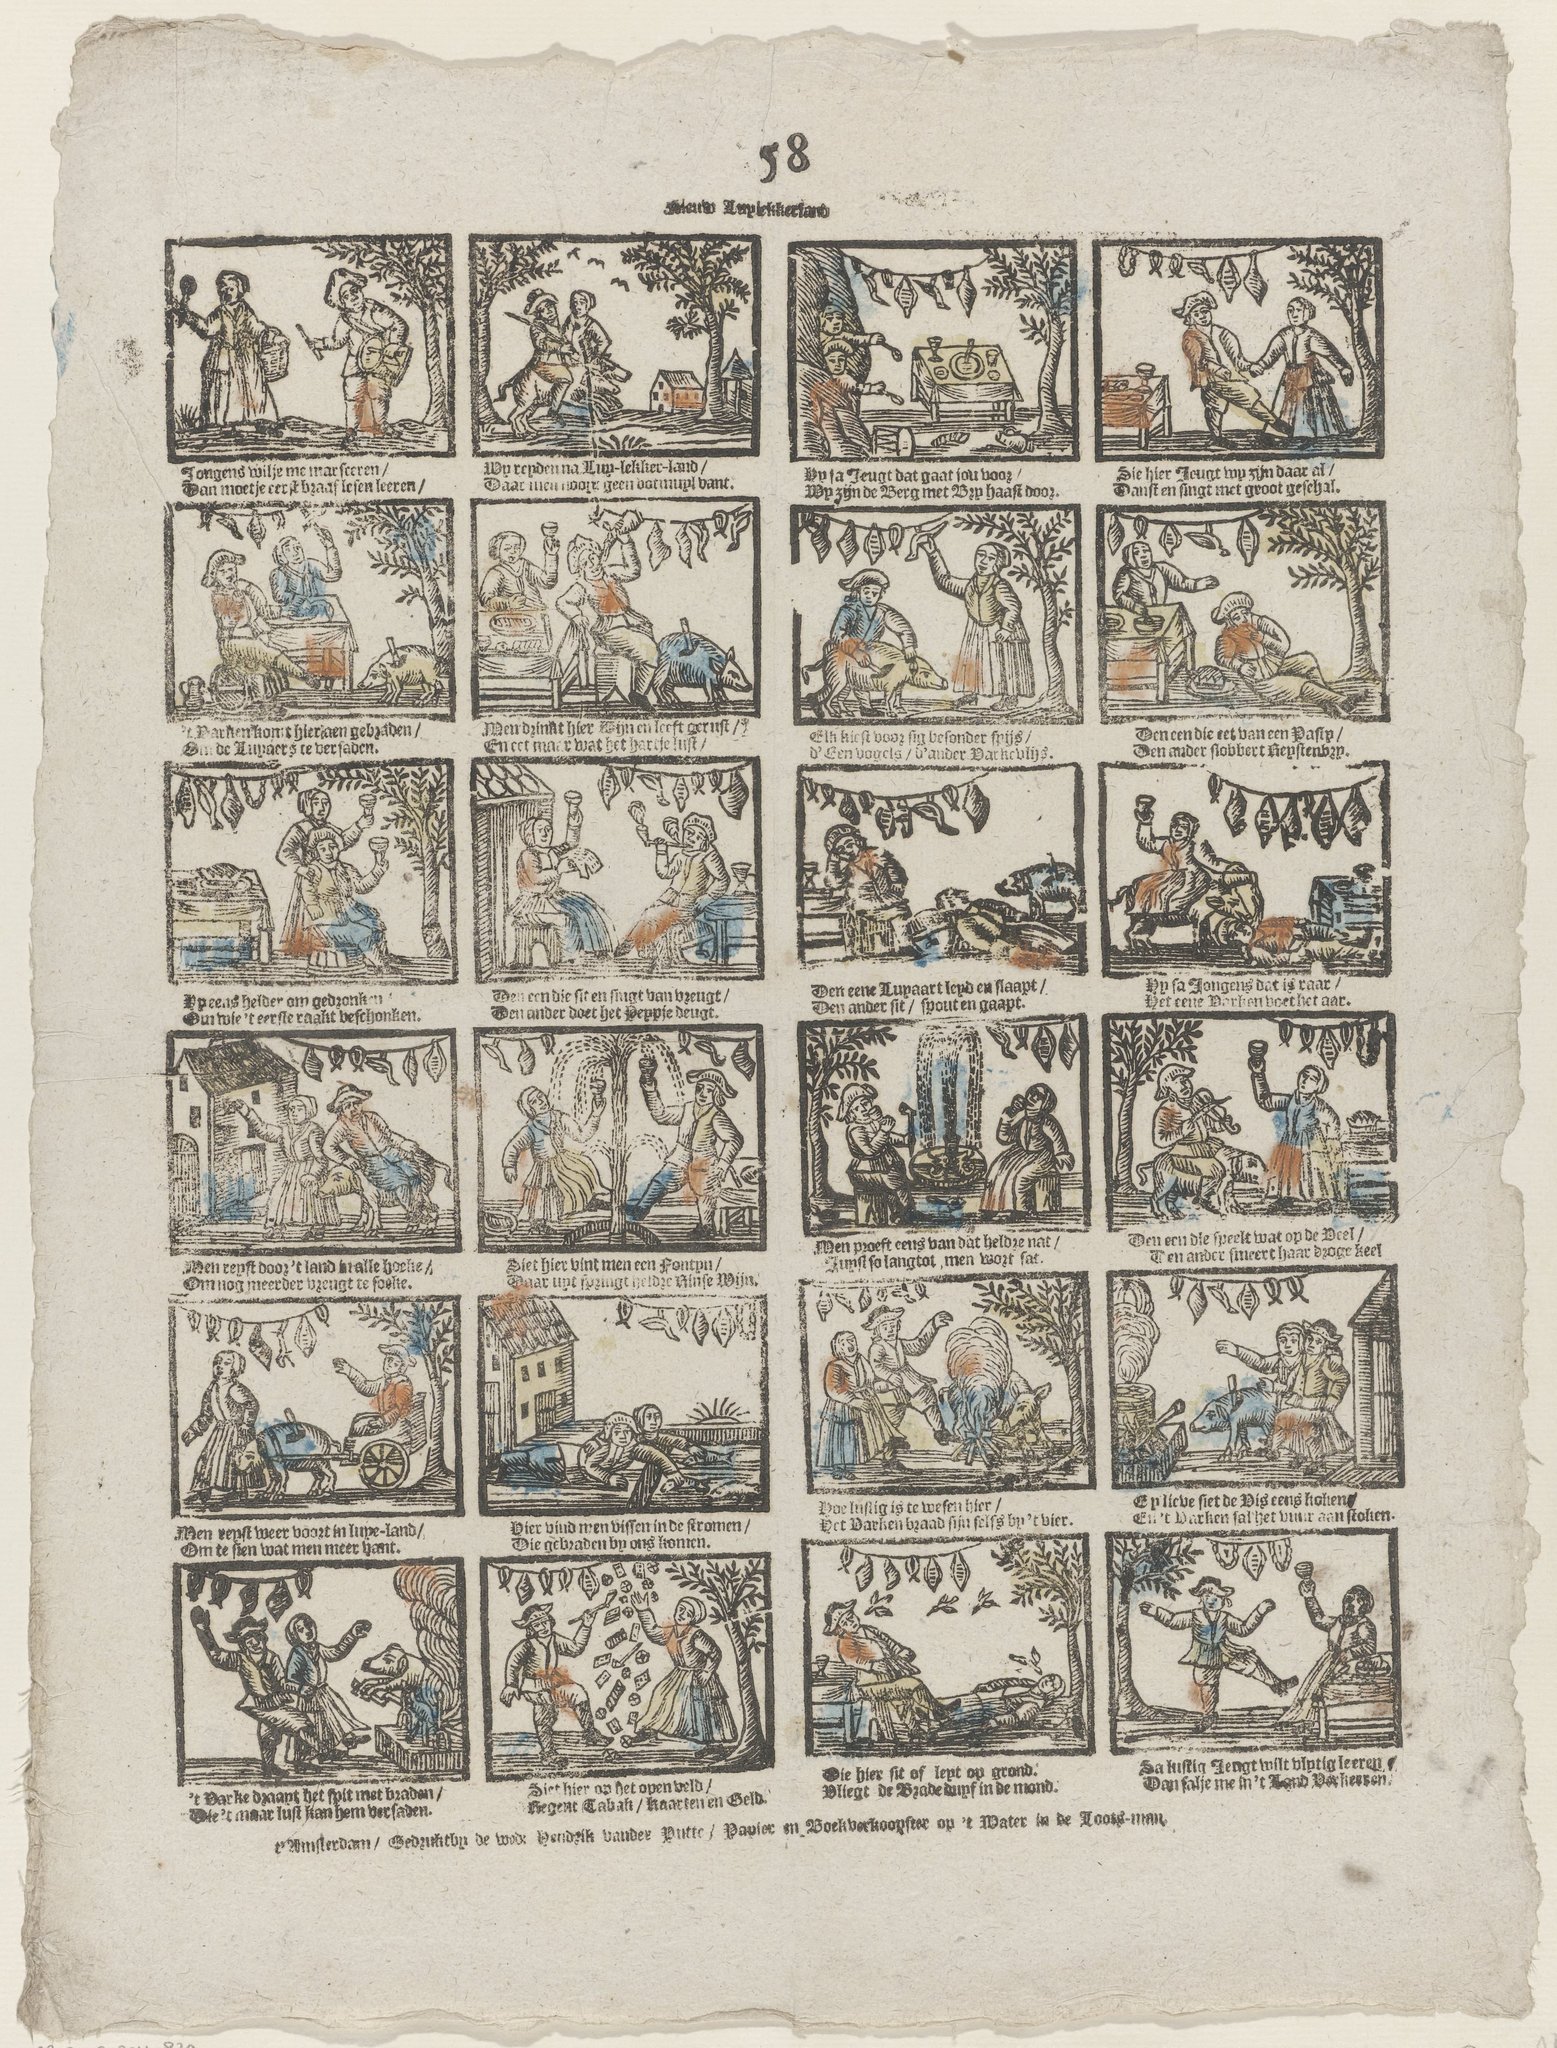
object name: print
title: Nieuw Luylekkerland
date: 1765-1767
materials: paper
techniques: colour, letterpress printing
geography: netherlands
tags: land of cockaigne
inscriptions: collector's mark: Lugt 2760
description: Blad met 24 voorstellingen van het Luilekkerland. Onder elke afbeelding een tweeregelig vers. Genummerd midden boven: 58.